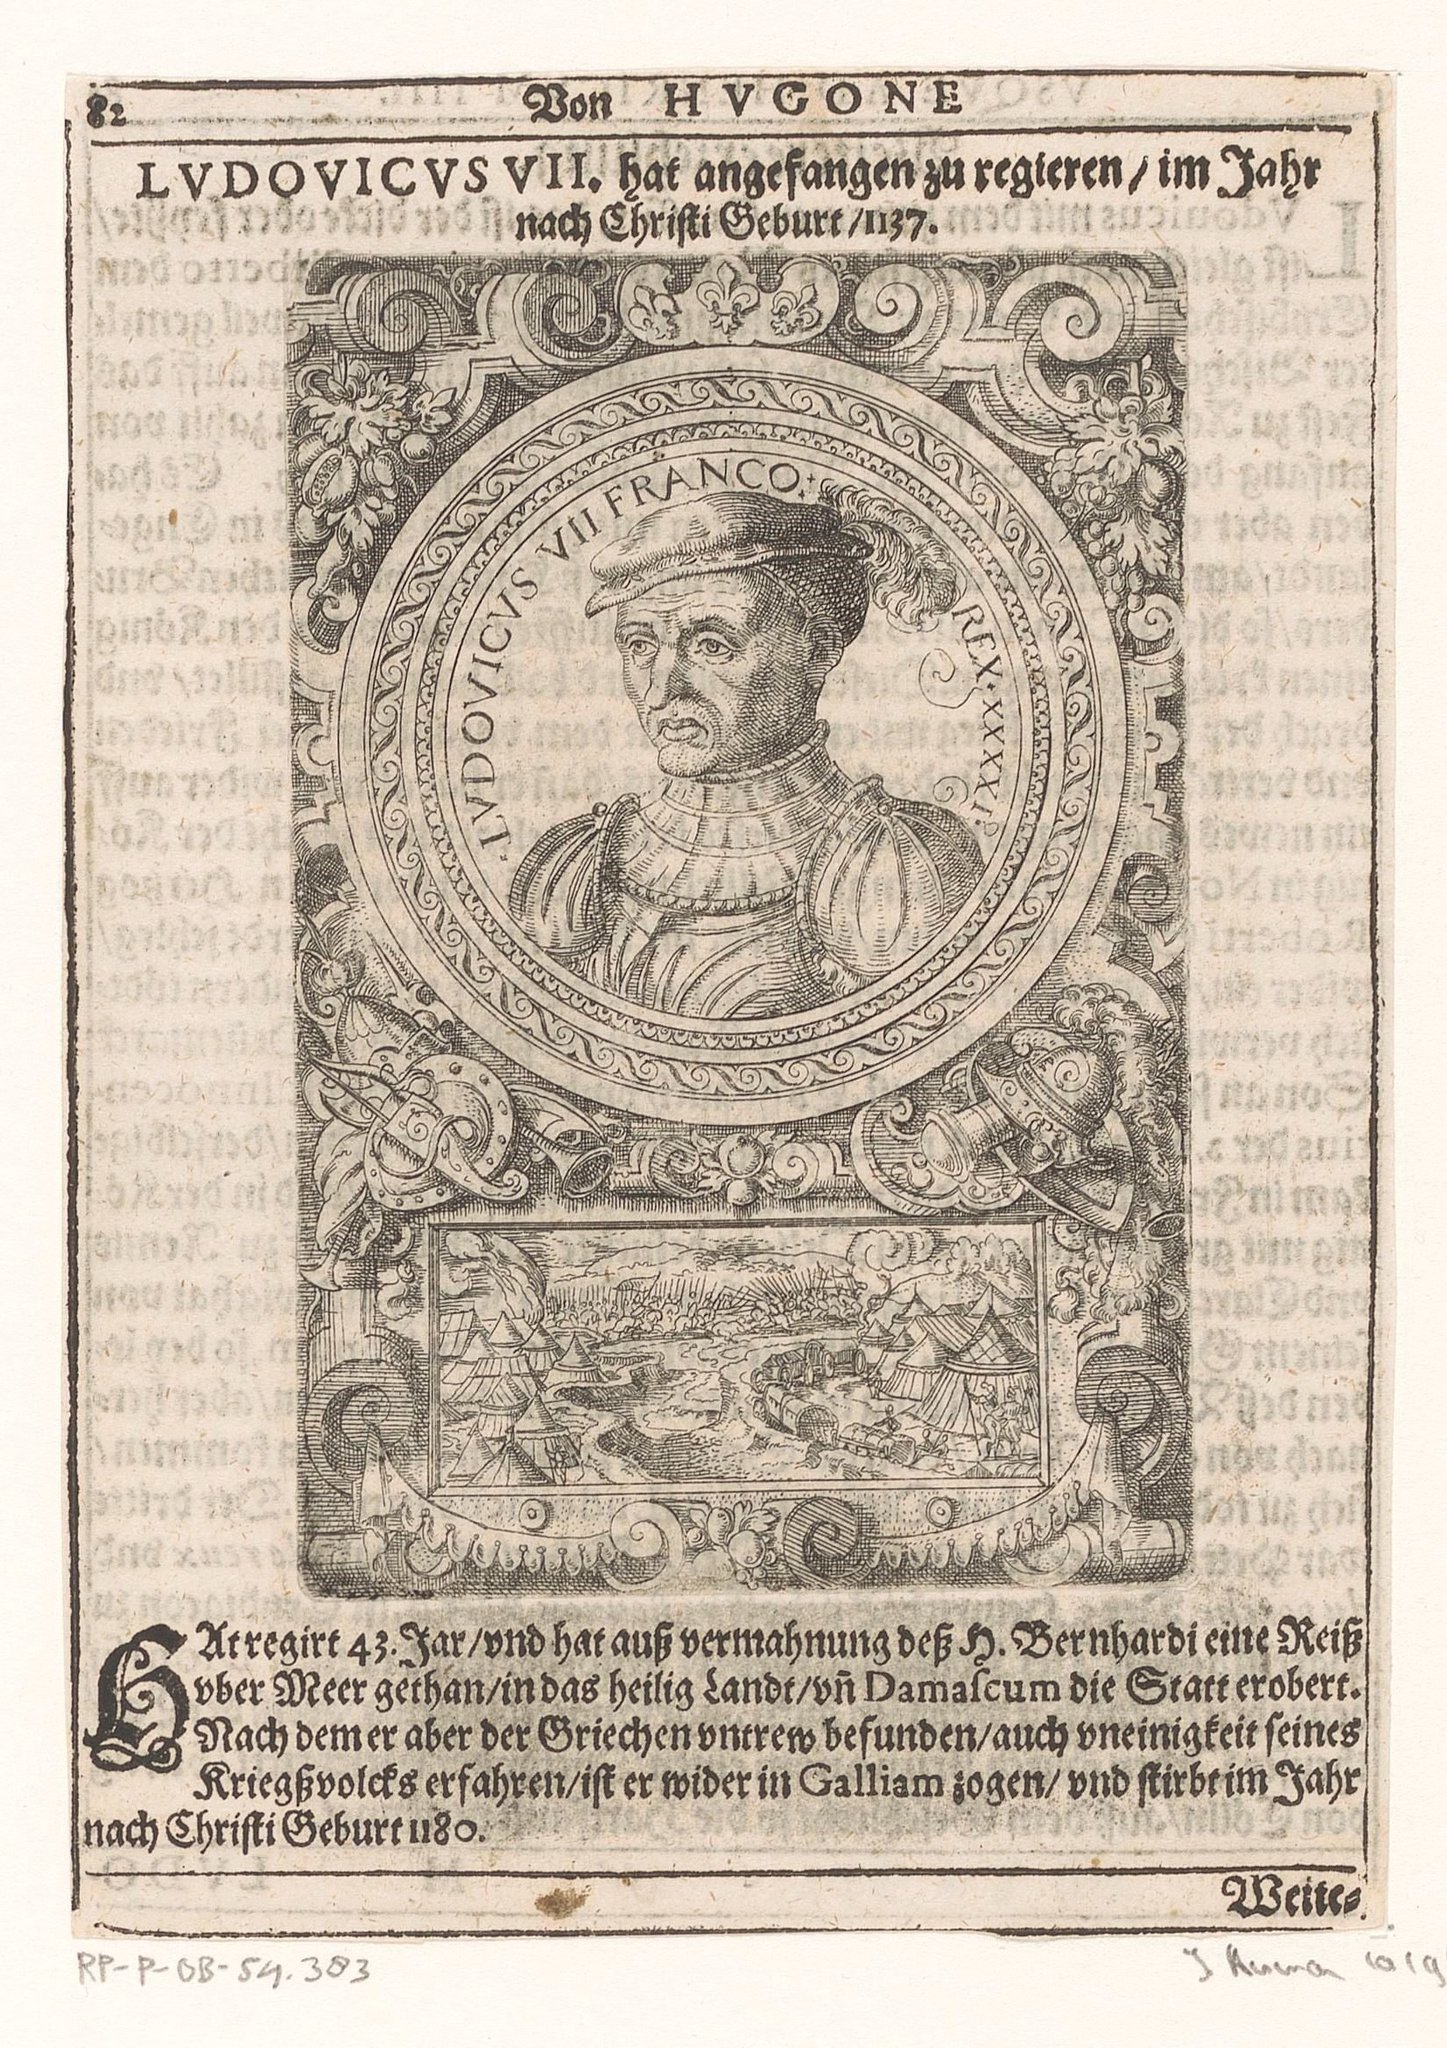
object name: book illustration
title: Portret van Lodewijk VII, koning van Frankrijk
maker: johann bussemacher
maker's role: print maker, printer, publisher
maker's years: -1627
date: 1598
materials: paper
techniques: etching, intaglio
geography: nuremberg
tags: paris, scrollwork, strapwork ~ ornament, historical persons, ruler, sovereign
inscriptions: collector's mark: Lugt 2228, number: ‘158’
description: Prent afkomstig uit de publicatie: Michael Eizinger. Könige in Frankreich. Keulen: Johann Bussemacher, 1598, p. 82. De publicatie bevat prenten van Jost Amman en Virgil Solis.